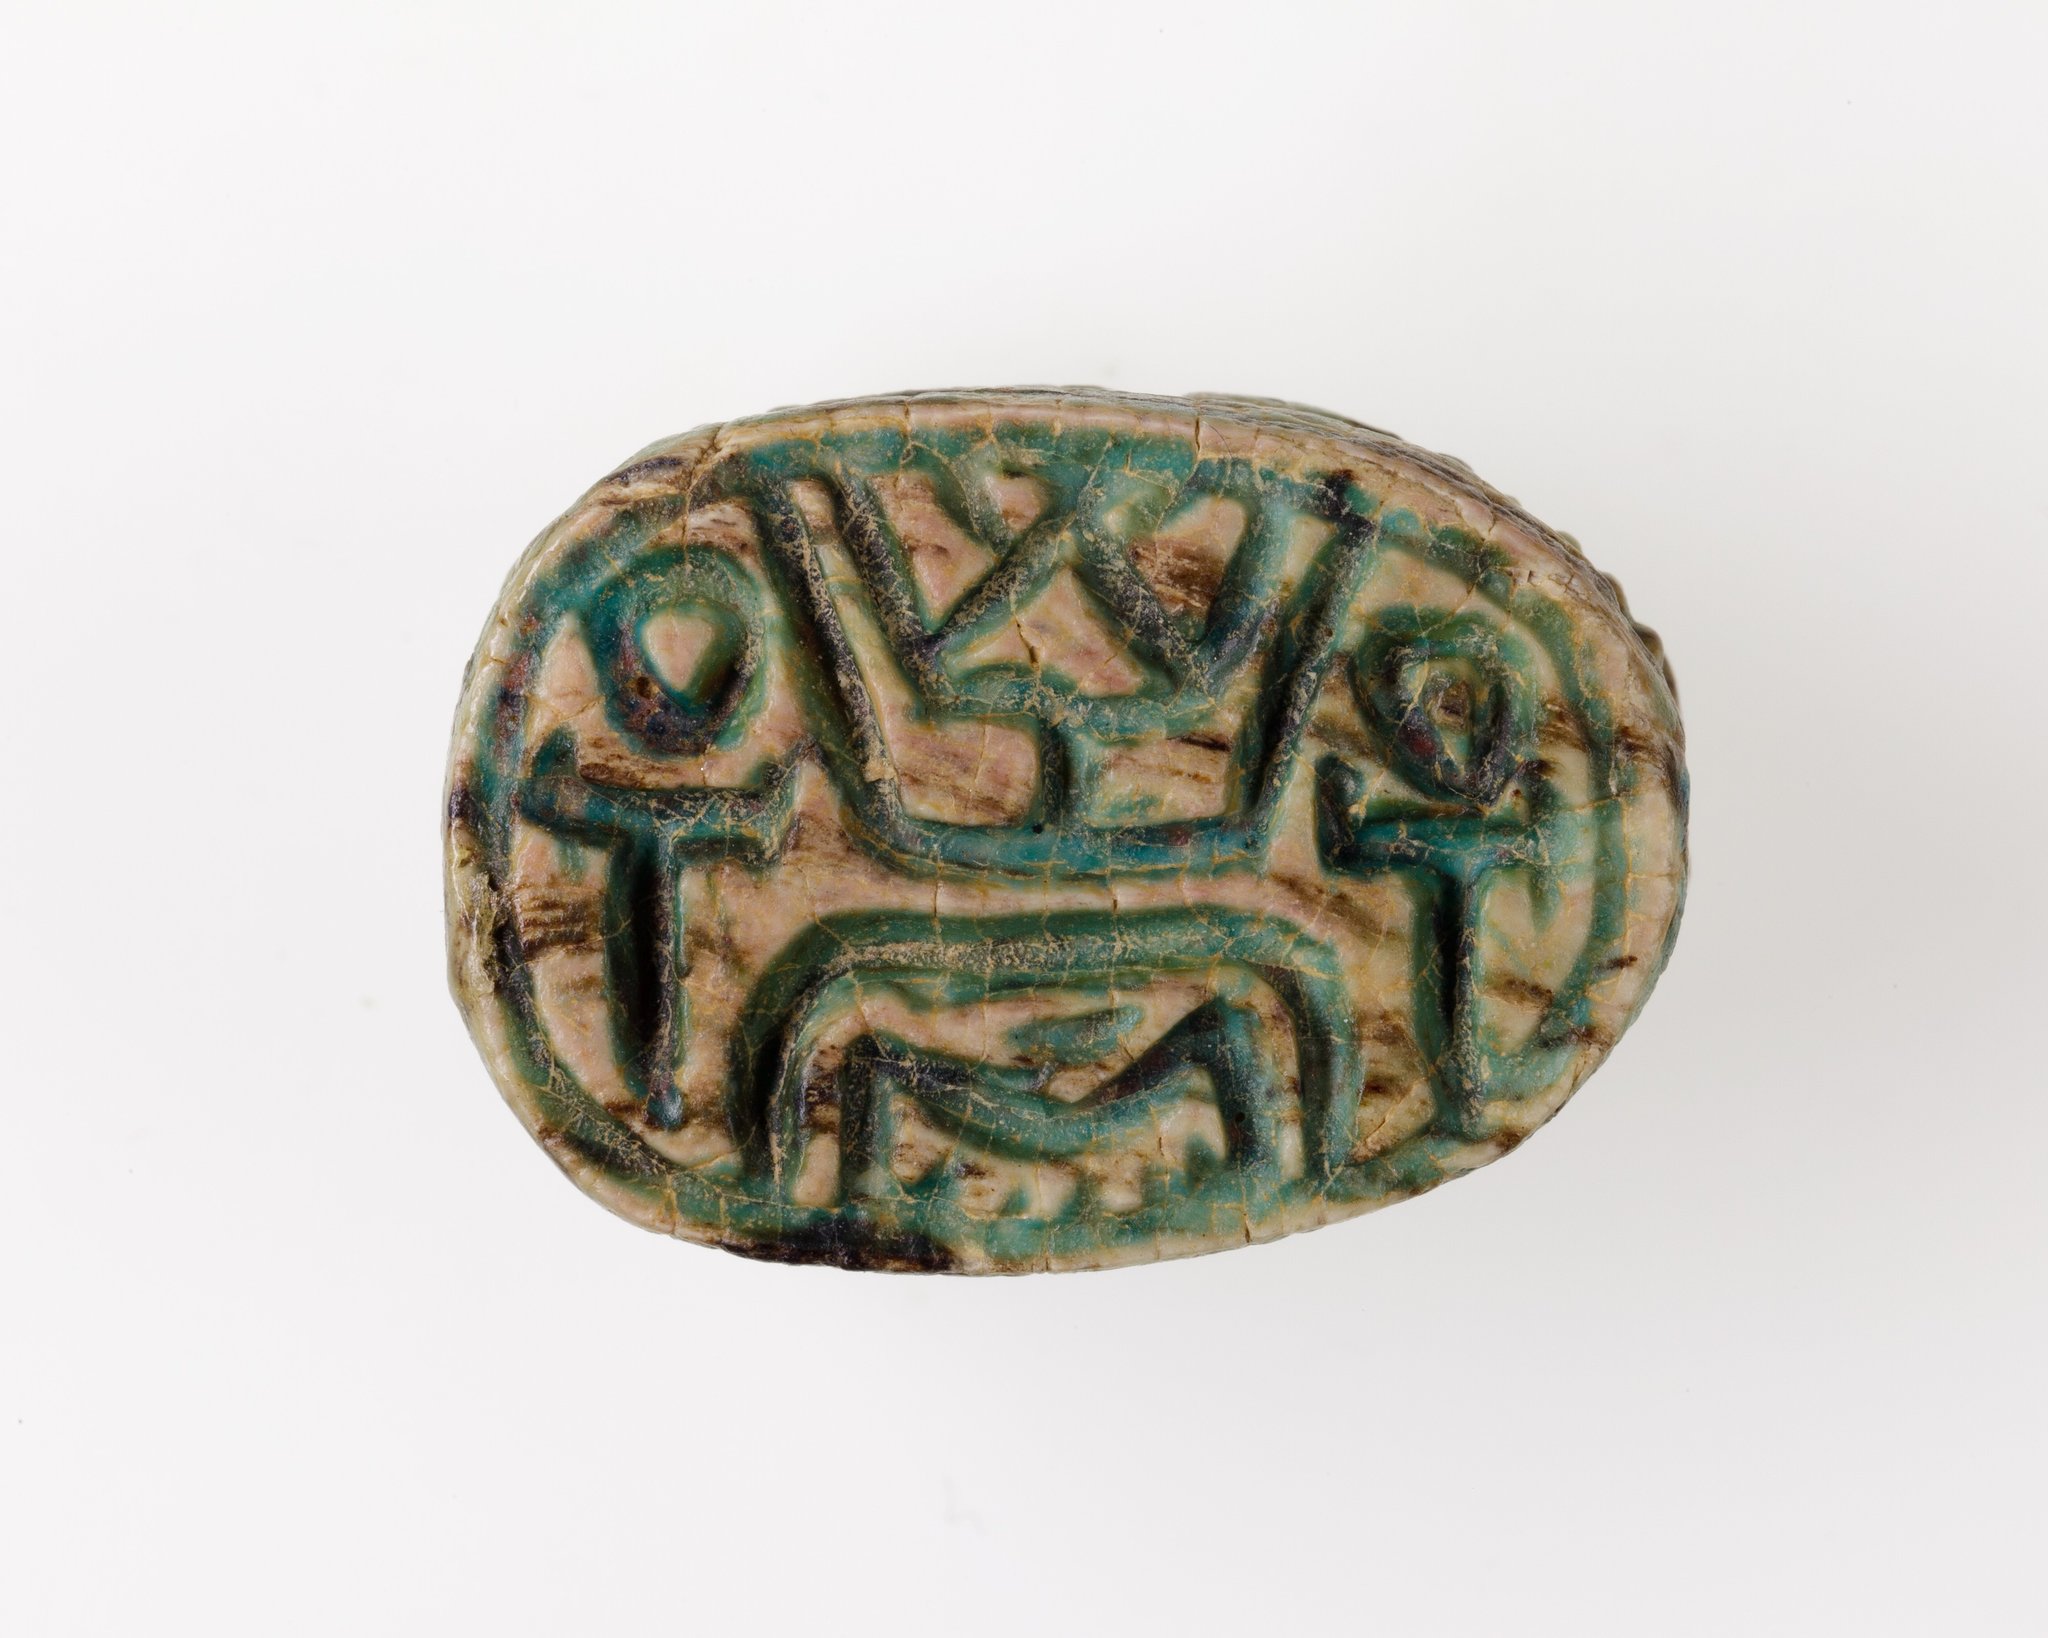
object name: scarab, hieroglyph, nbw gold, red crown, ankh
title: Scarab Inscribed with Hieroglyphs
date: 1850-1640 BCE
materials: stone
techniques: glazing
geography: egypt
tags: hieroglyphs,scarabs